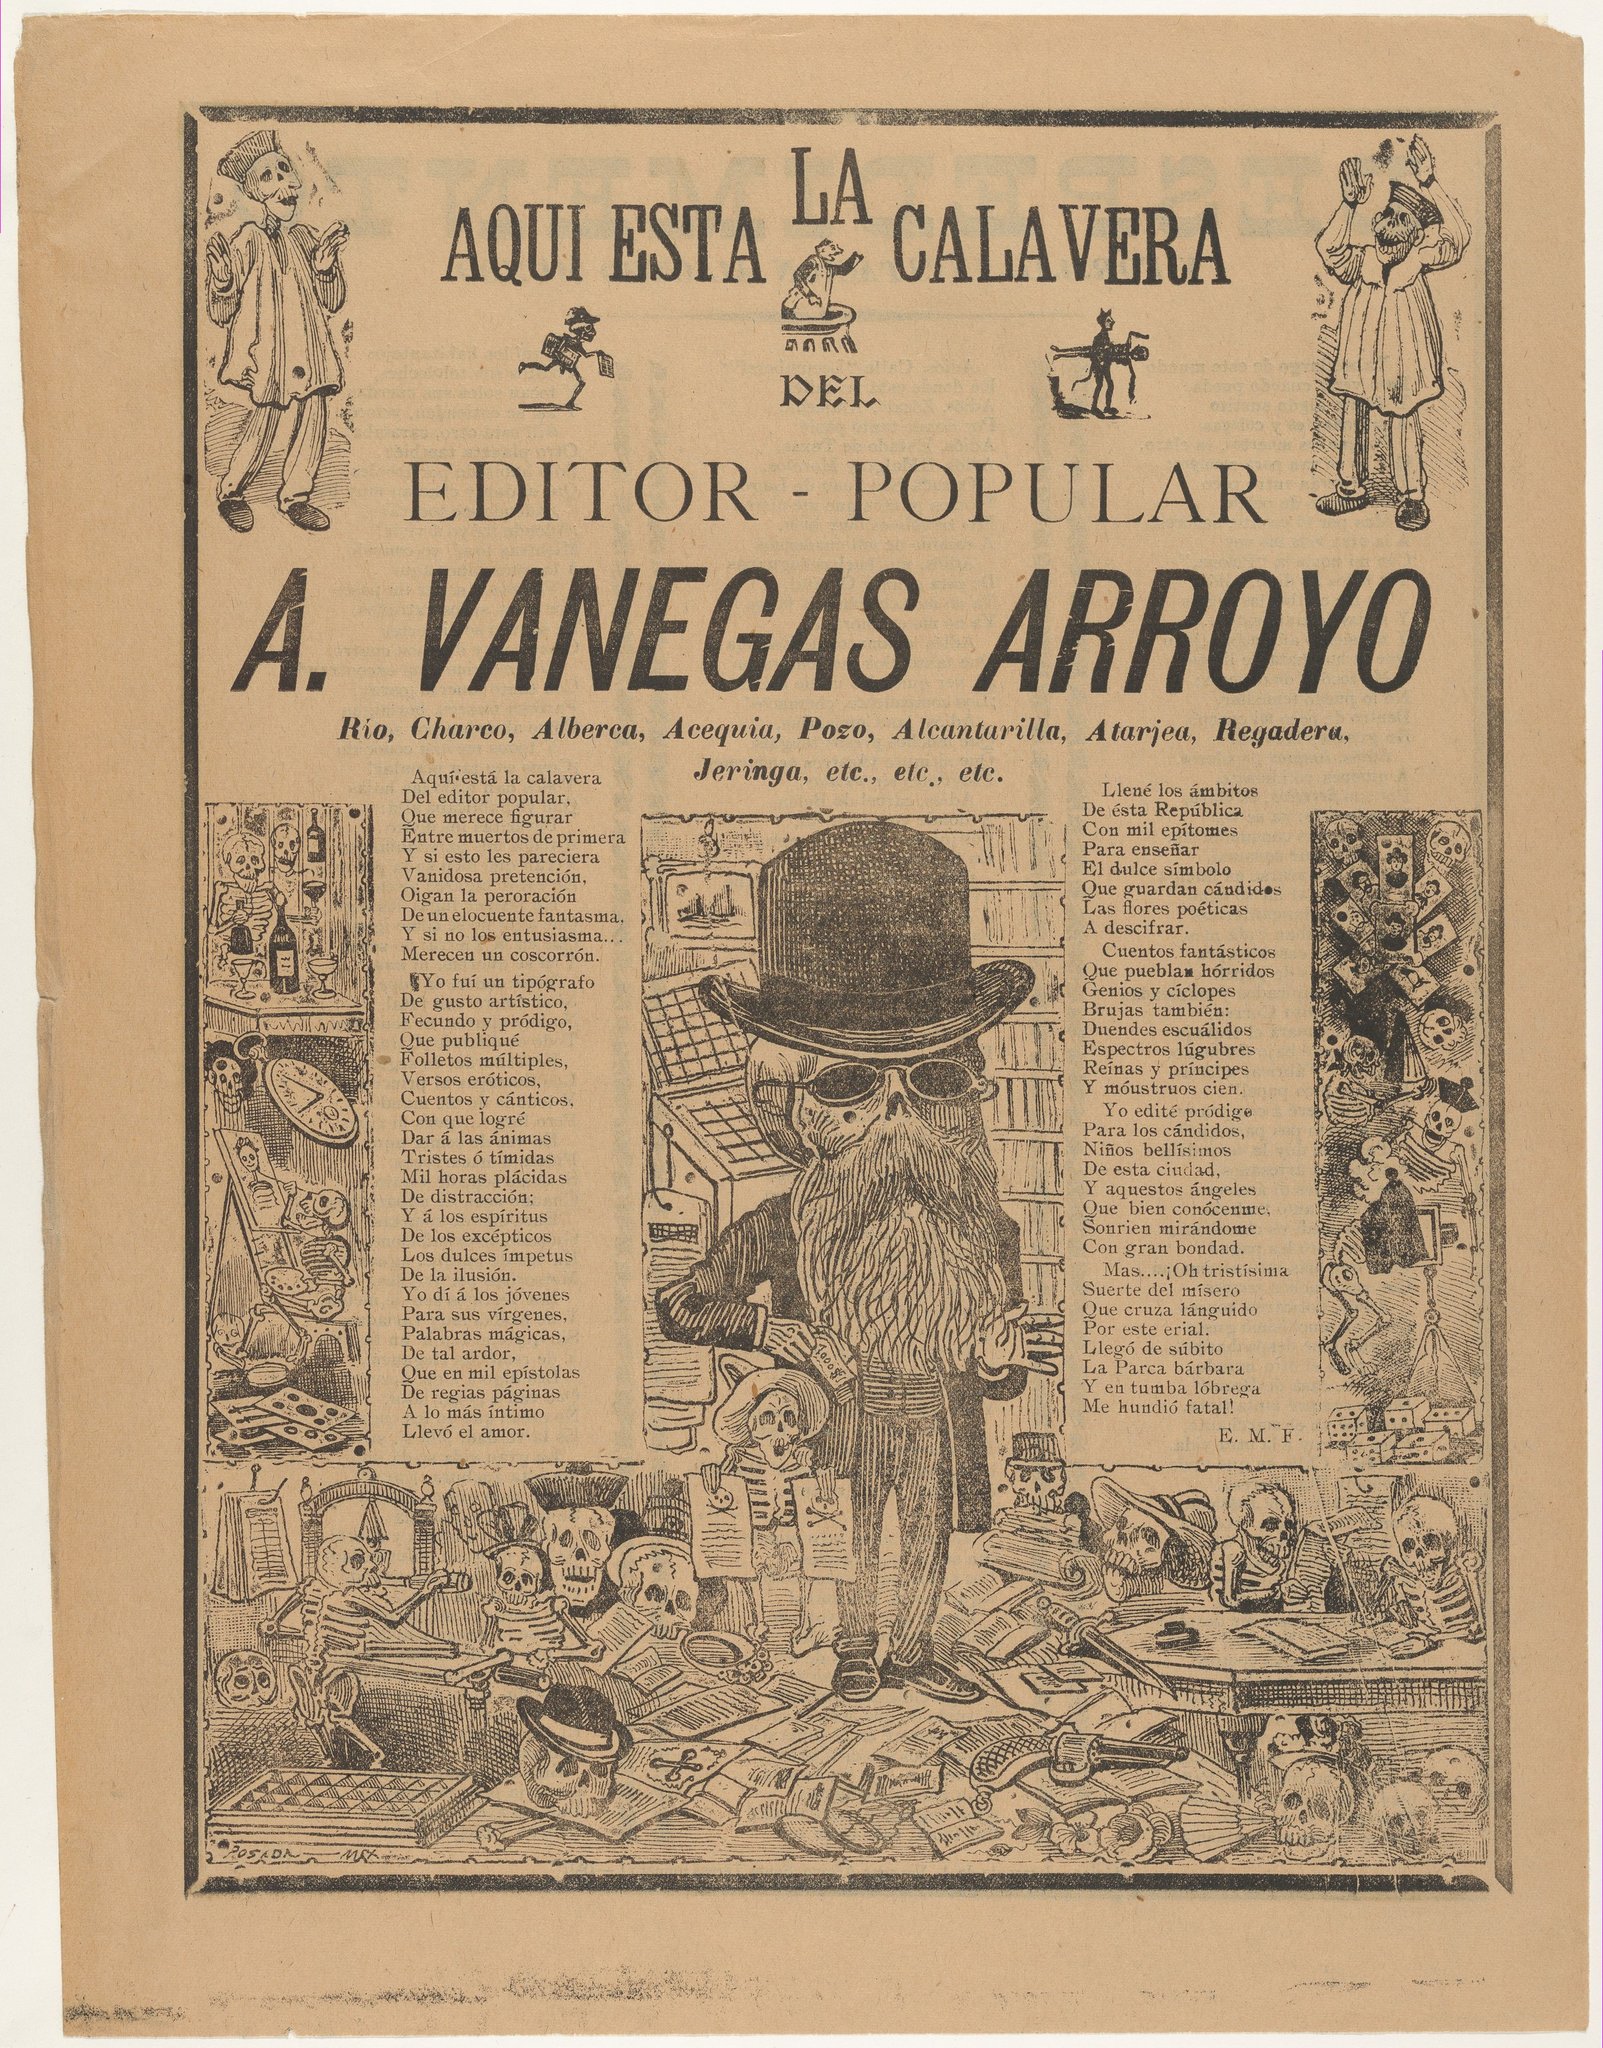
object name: print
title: The skeleton of the people’s editor (Antonio Vanegas Arroyo)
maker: josé guadalupe posada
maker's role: artist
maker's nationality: mexican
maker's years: 1852-1913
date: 1902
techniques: letterpress, lithography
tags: skeletons